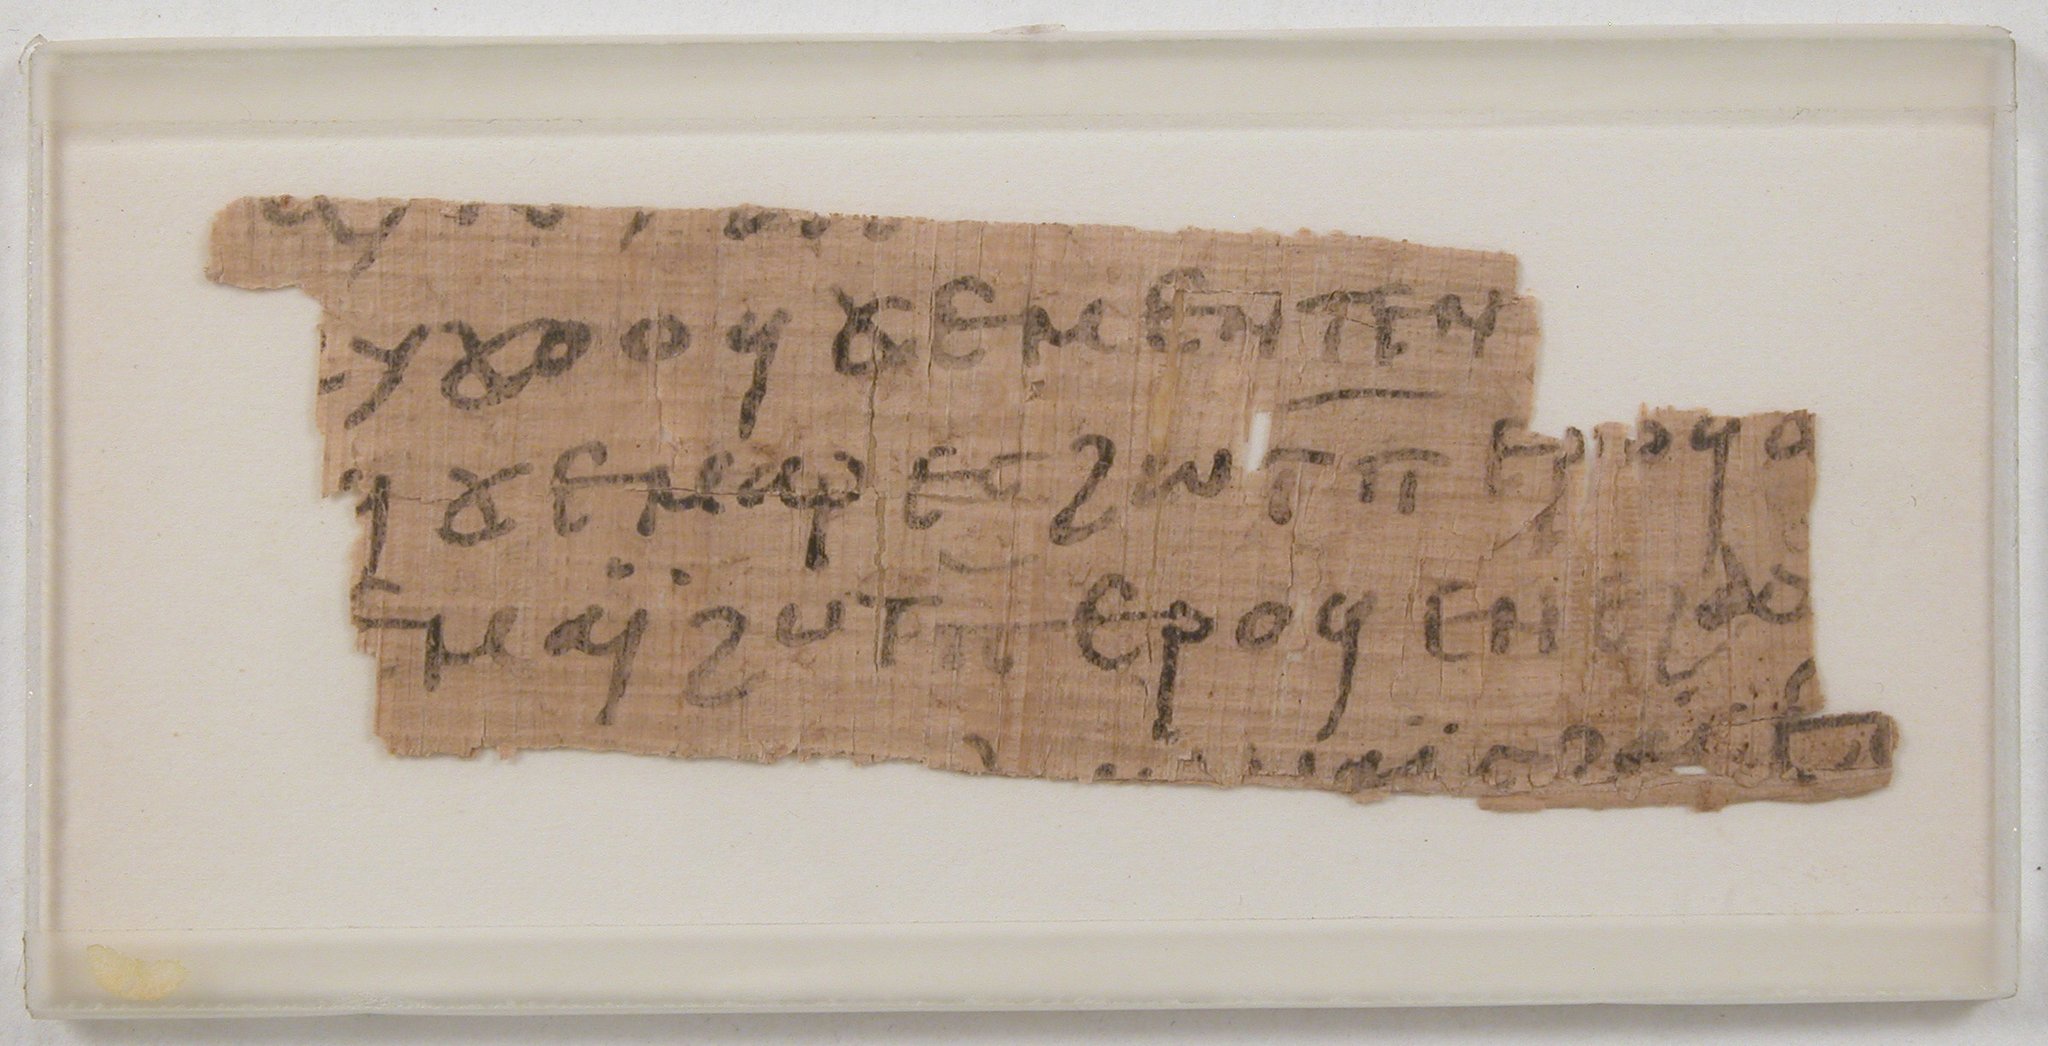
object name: fragment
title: Papyrus Fragment of a Letter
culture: coptic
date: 601-700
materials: ink, papyrus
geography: egypt